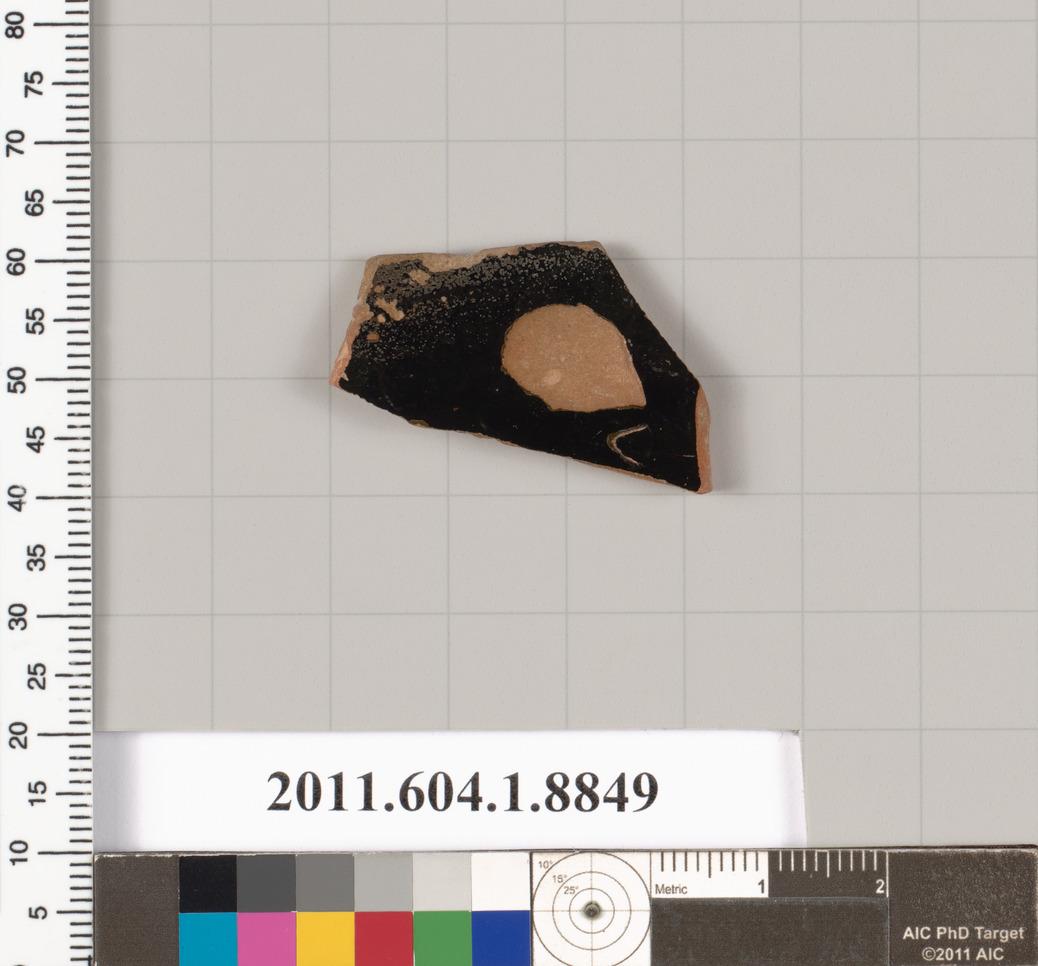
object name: kylix fragment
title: Terracotta fragment of a kylix (drinking cup)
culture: greek, attic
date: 500-470 BCE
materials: terracotta